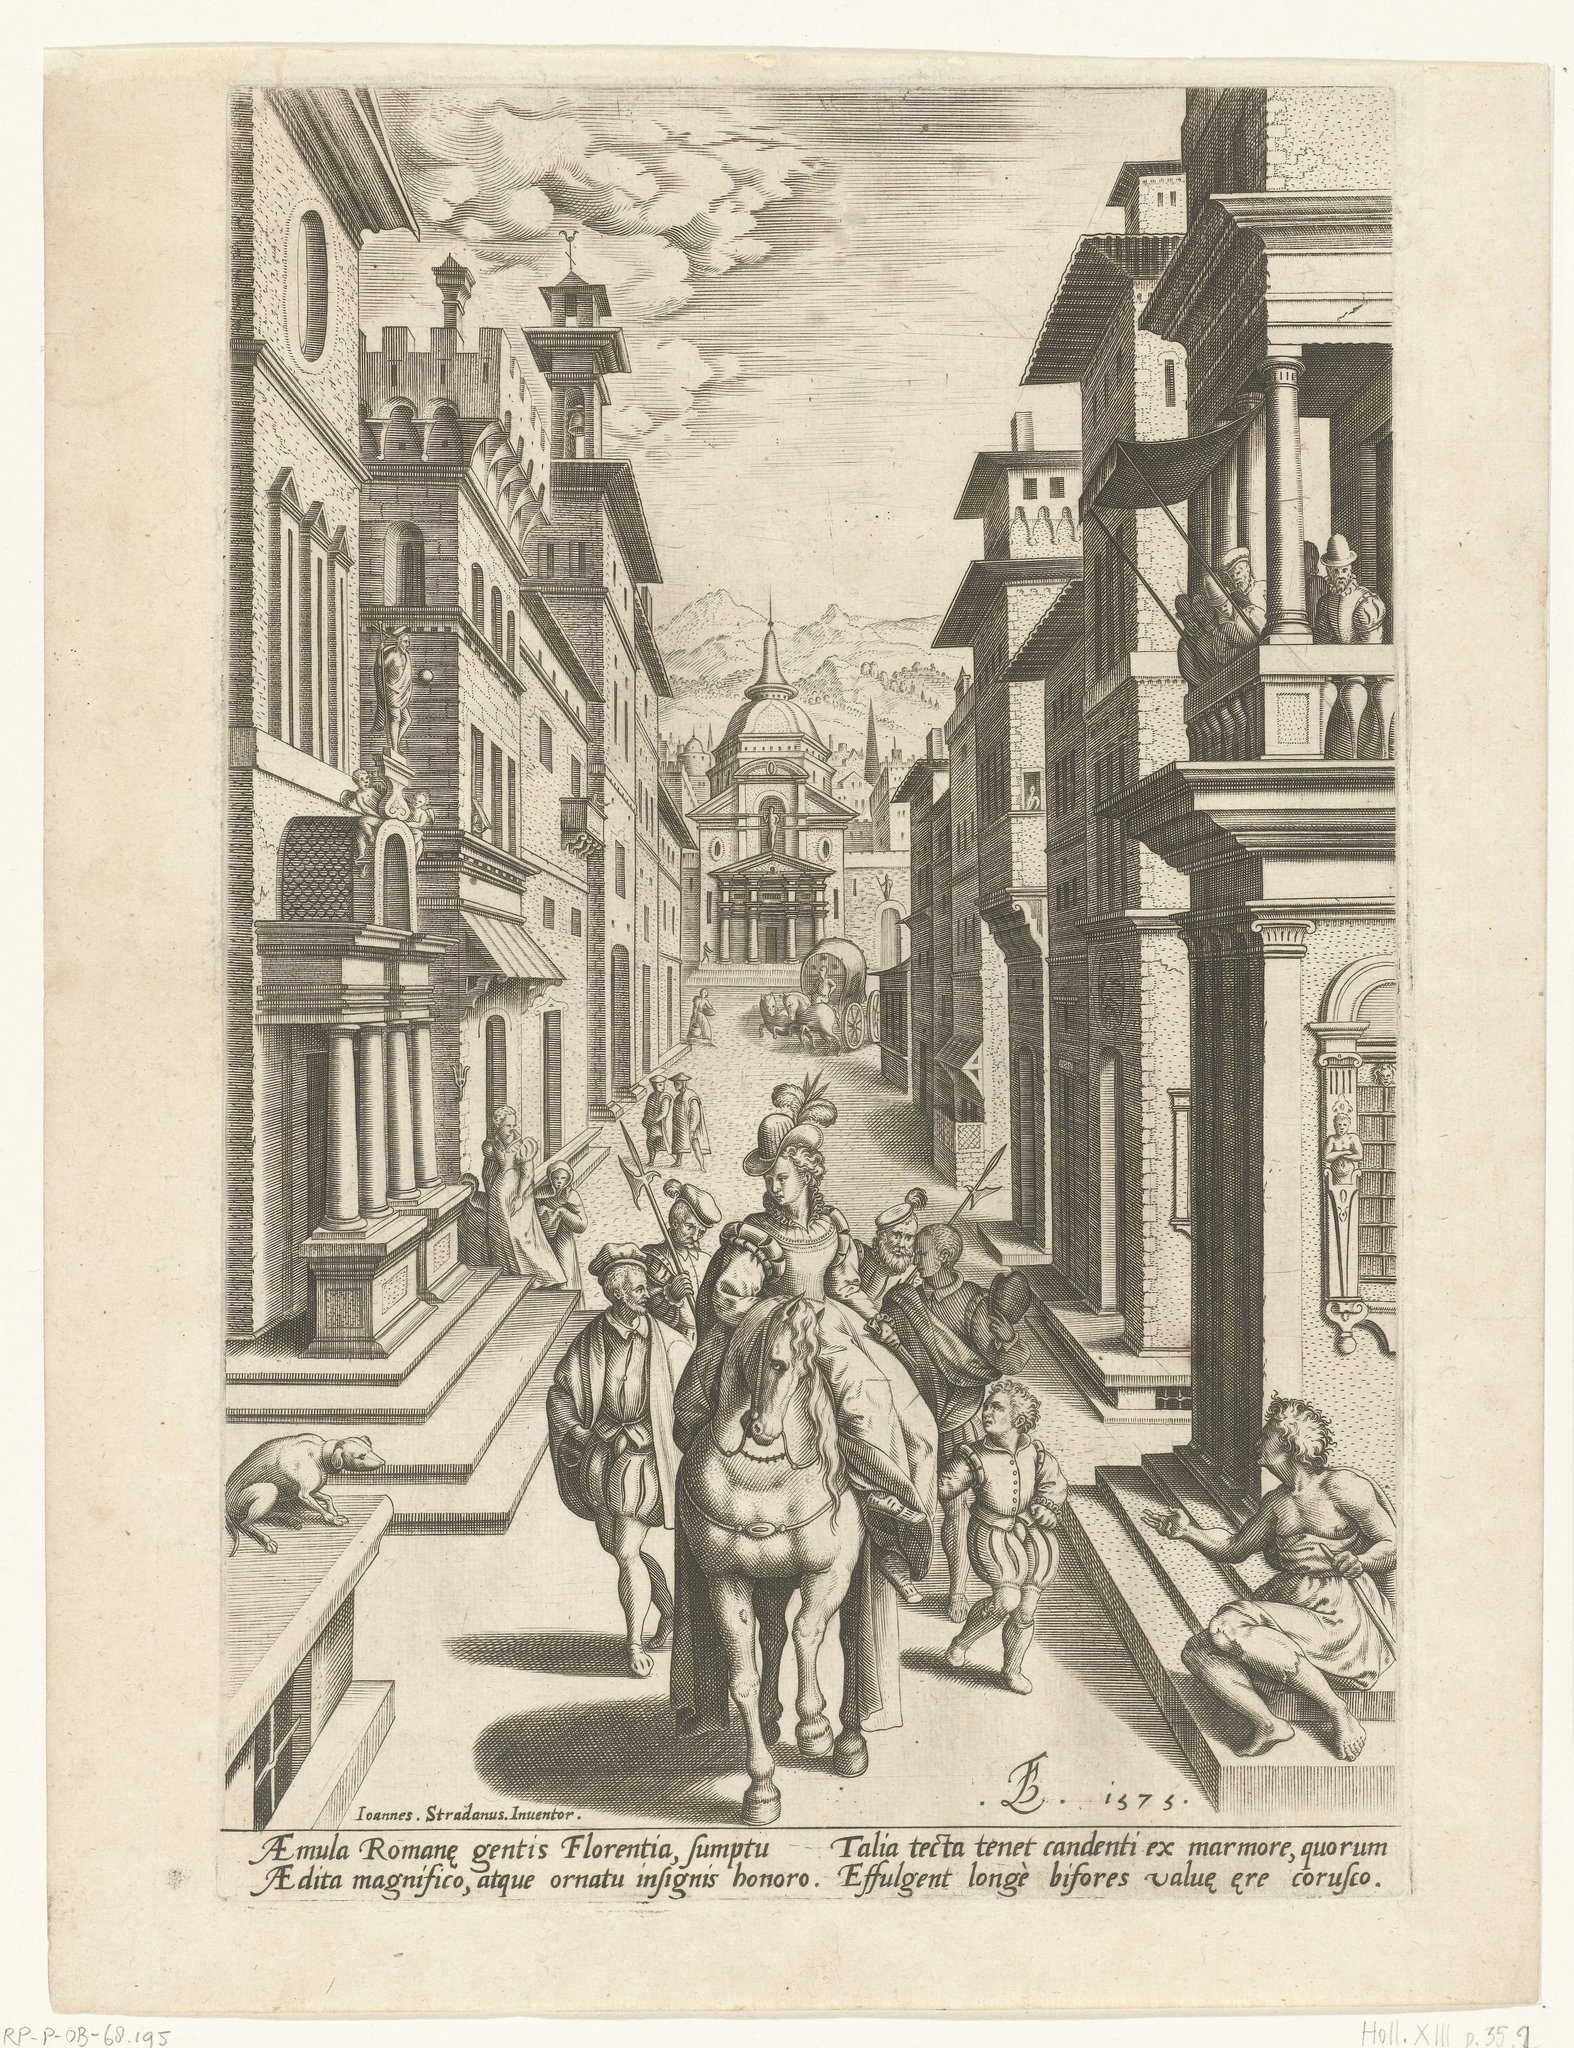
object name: print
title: Dame te paard in Florence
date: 1575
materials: paper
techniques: engraving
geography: antwerp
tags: prague, riding a horse, ass, or mule; rider, horseman, street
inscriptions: date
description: Een dame, mogelijk Johanna van Oostenrijk, rijdt te paard door een straat in Florence. Ze wordt begeleid door vier mannen en een jongen. Rechtsvoor zit een bedelaar. Linksvoor een hond. Onder in de marge een vierregelig onderschrift in het Latijn.